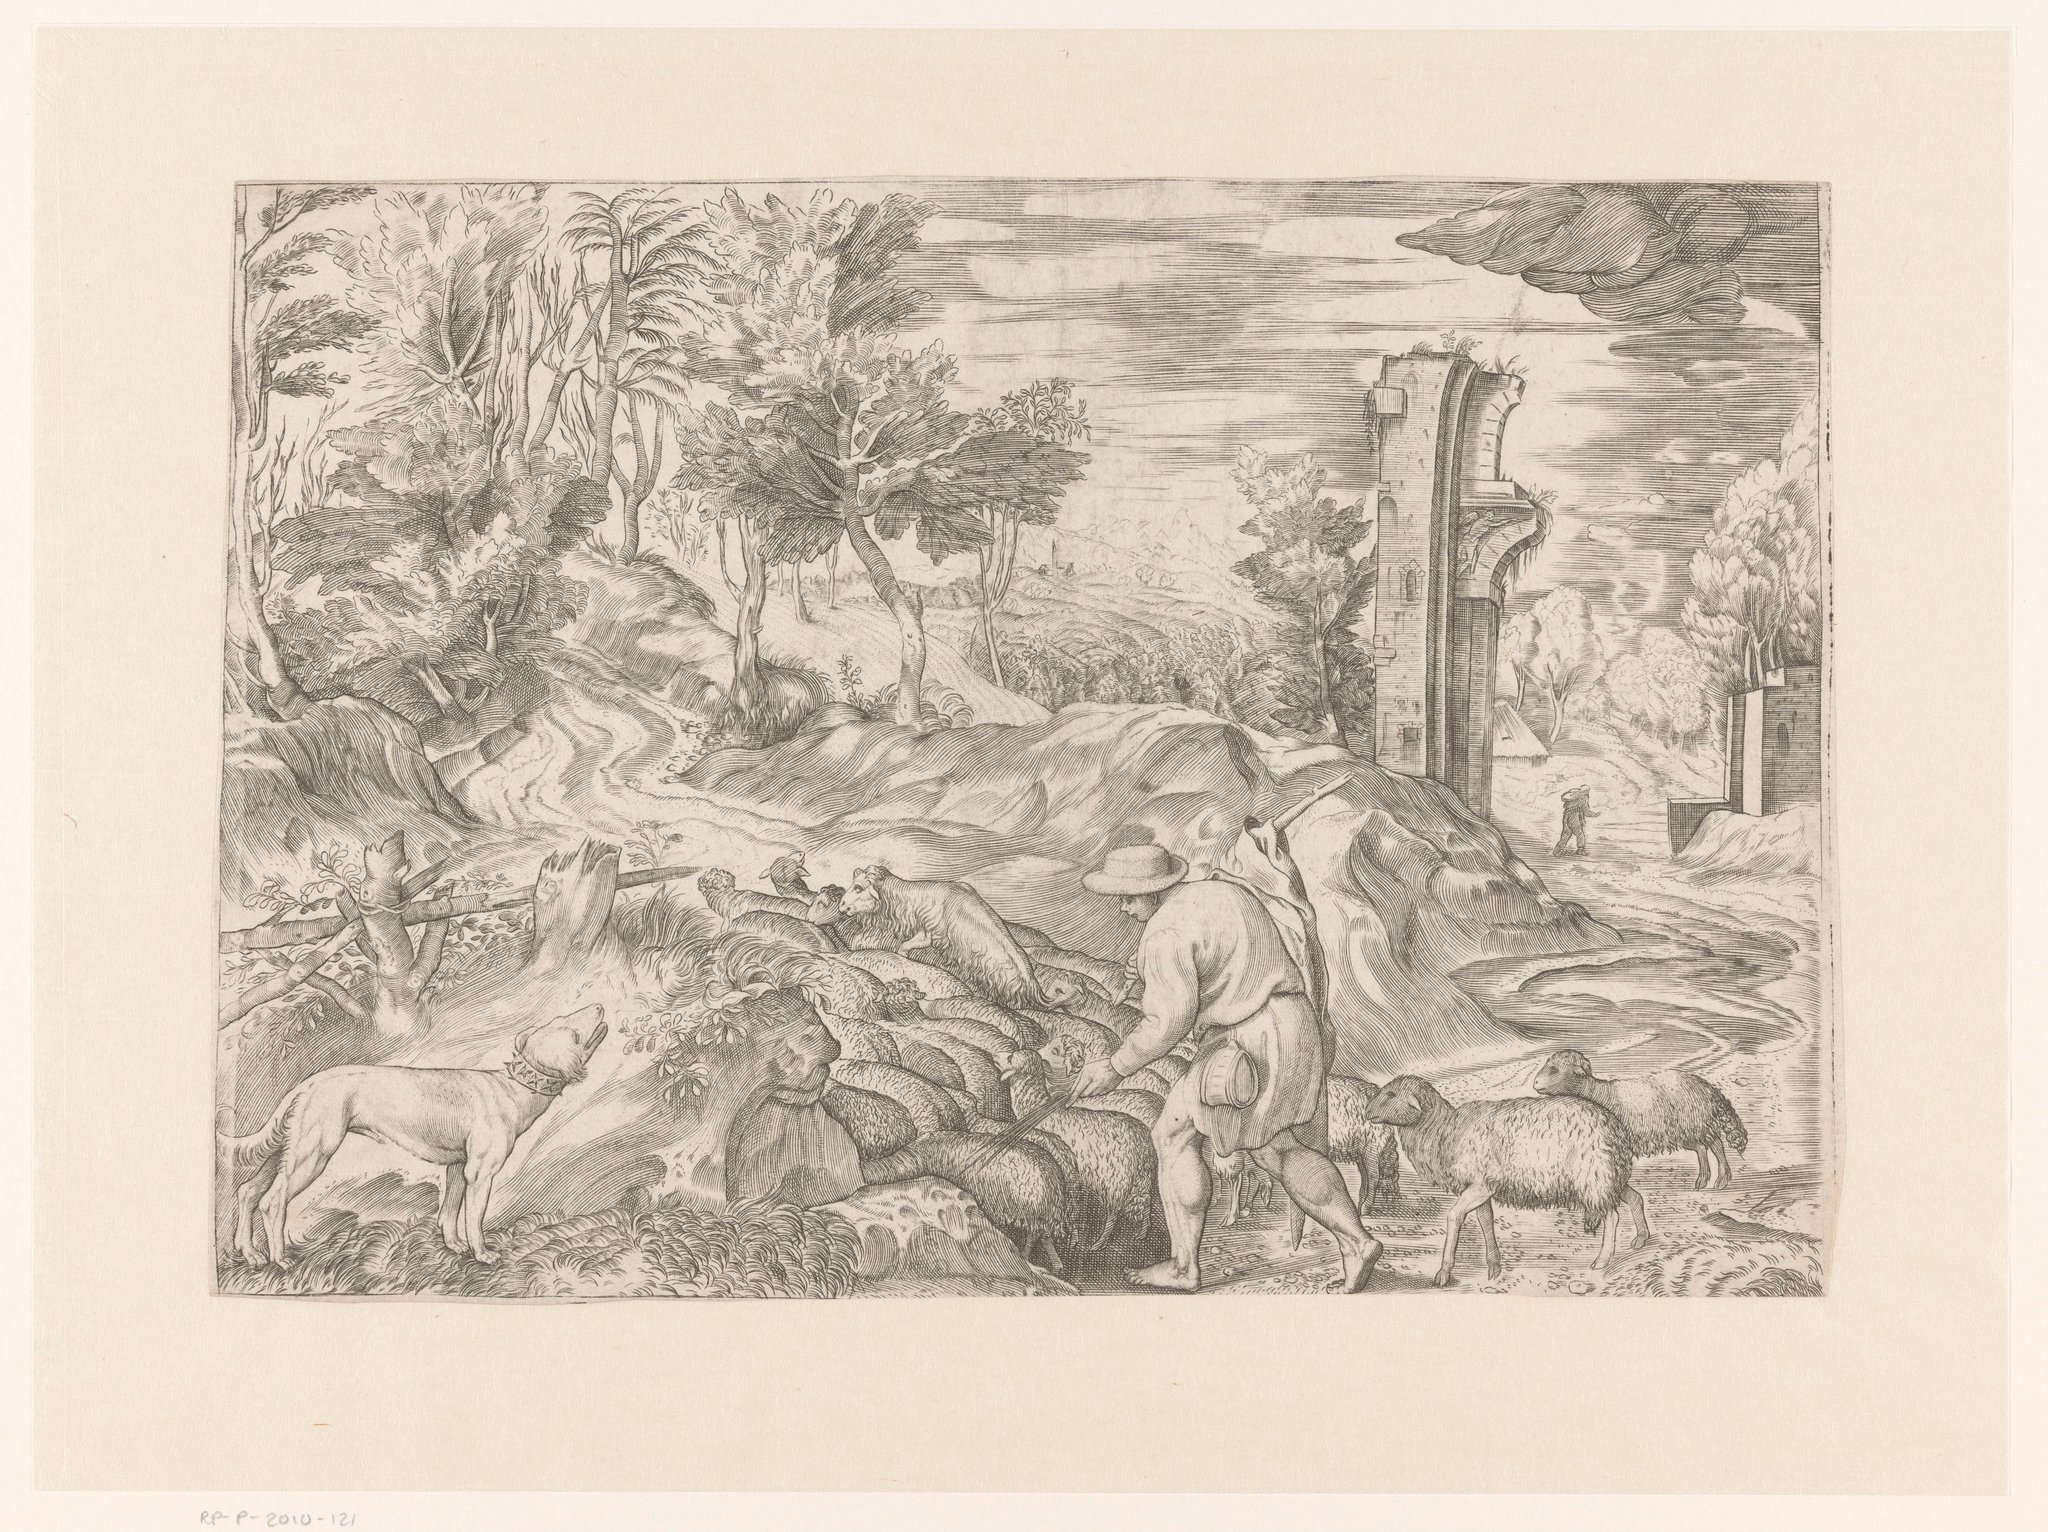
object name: print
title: Landschap met herder en kudde schapen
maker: monogrammist db (etser 16de eeuw)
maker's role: print maker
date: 1550-1600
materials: paper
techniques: etching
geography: italy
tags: herding, herdsman, herdswoman, shepherd, shepherdess, cowherd, etc., landscape with ruins, herd, flock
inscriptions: collector's mark: Lugt 2228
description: Een jonge herder met zomerhoed leidt zijn kudde schapen op een heuvel links. Zijn hond kijkt toe op de voorgrond links. Op de achtergrond tekent zich links een bosrijke heuvel en rechts een antieke ruïne af en een wandelaar.